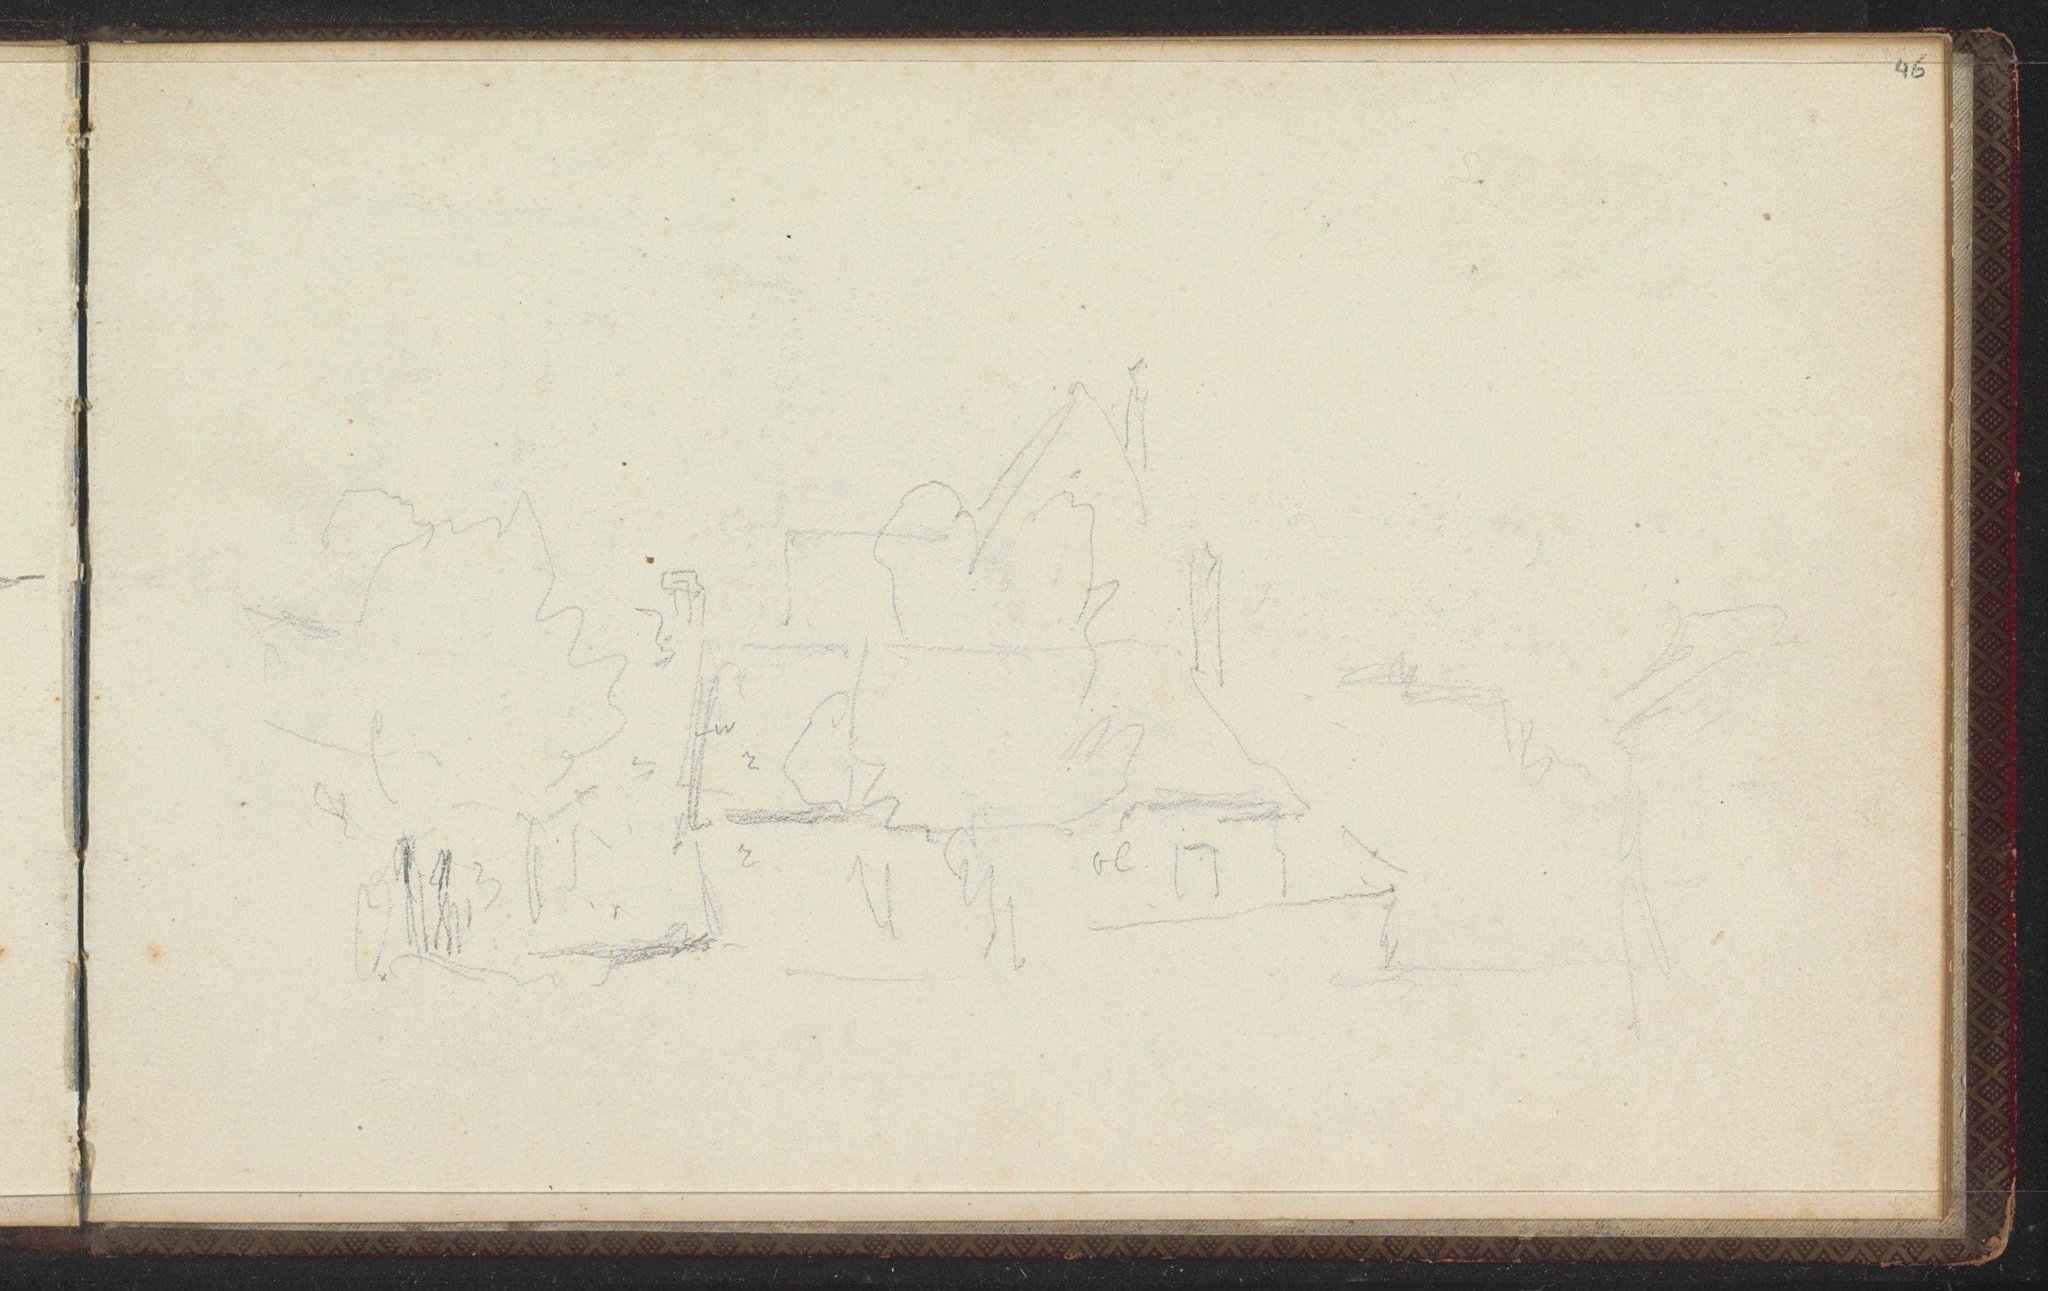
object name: sketchbook leaf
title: Gezicht op gebouwen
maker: adrianus eversen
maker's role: draughtsman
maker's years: 1818-1897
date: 1828-1897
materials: paper, pencil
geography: netherlands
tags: trees, civic architecture; edifices; dwellings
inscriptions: kleurnotitie, handgeschreven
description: Gezicht op gebouwen en bomen. Blad 46 recto uit een schetsboek met 52 bladen vervaardigd in de omgeving van Kampen, Hattem, Hoorn en Zwolle.